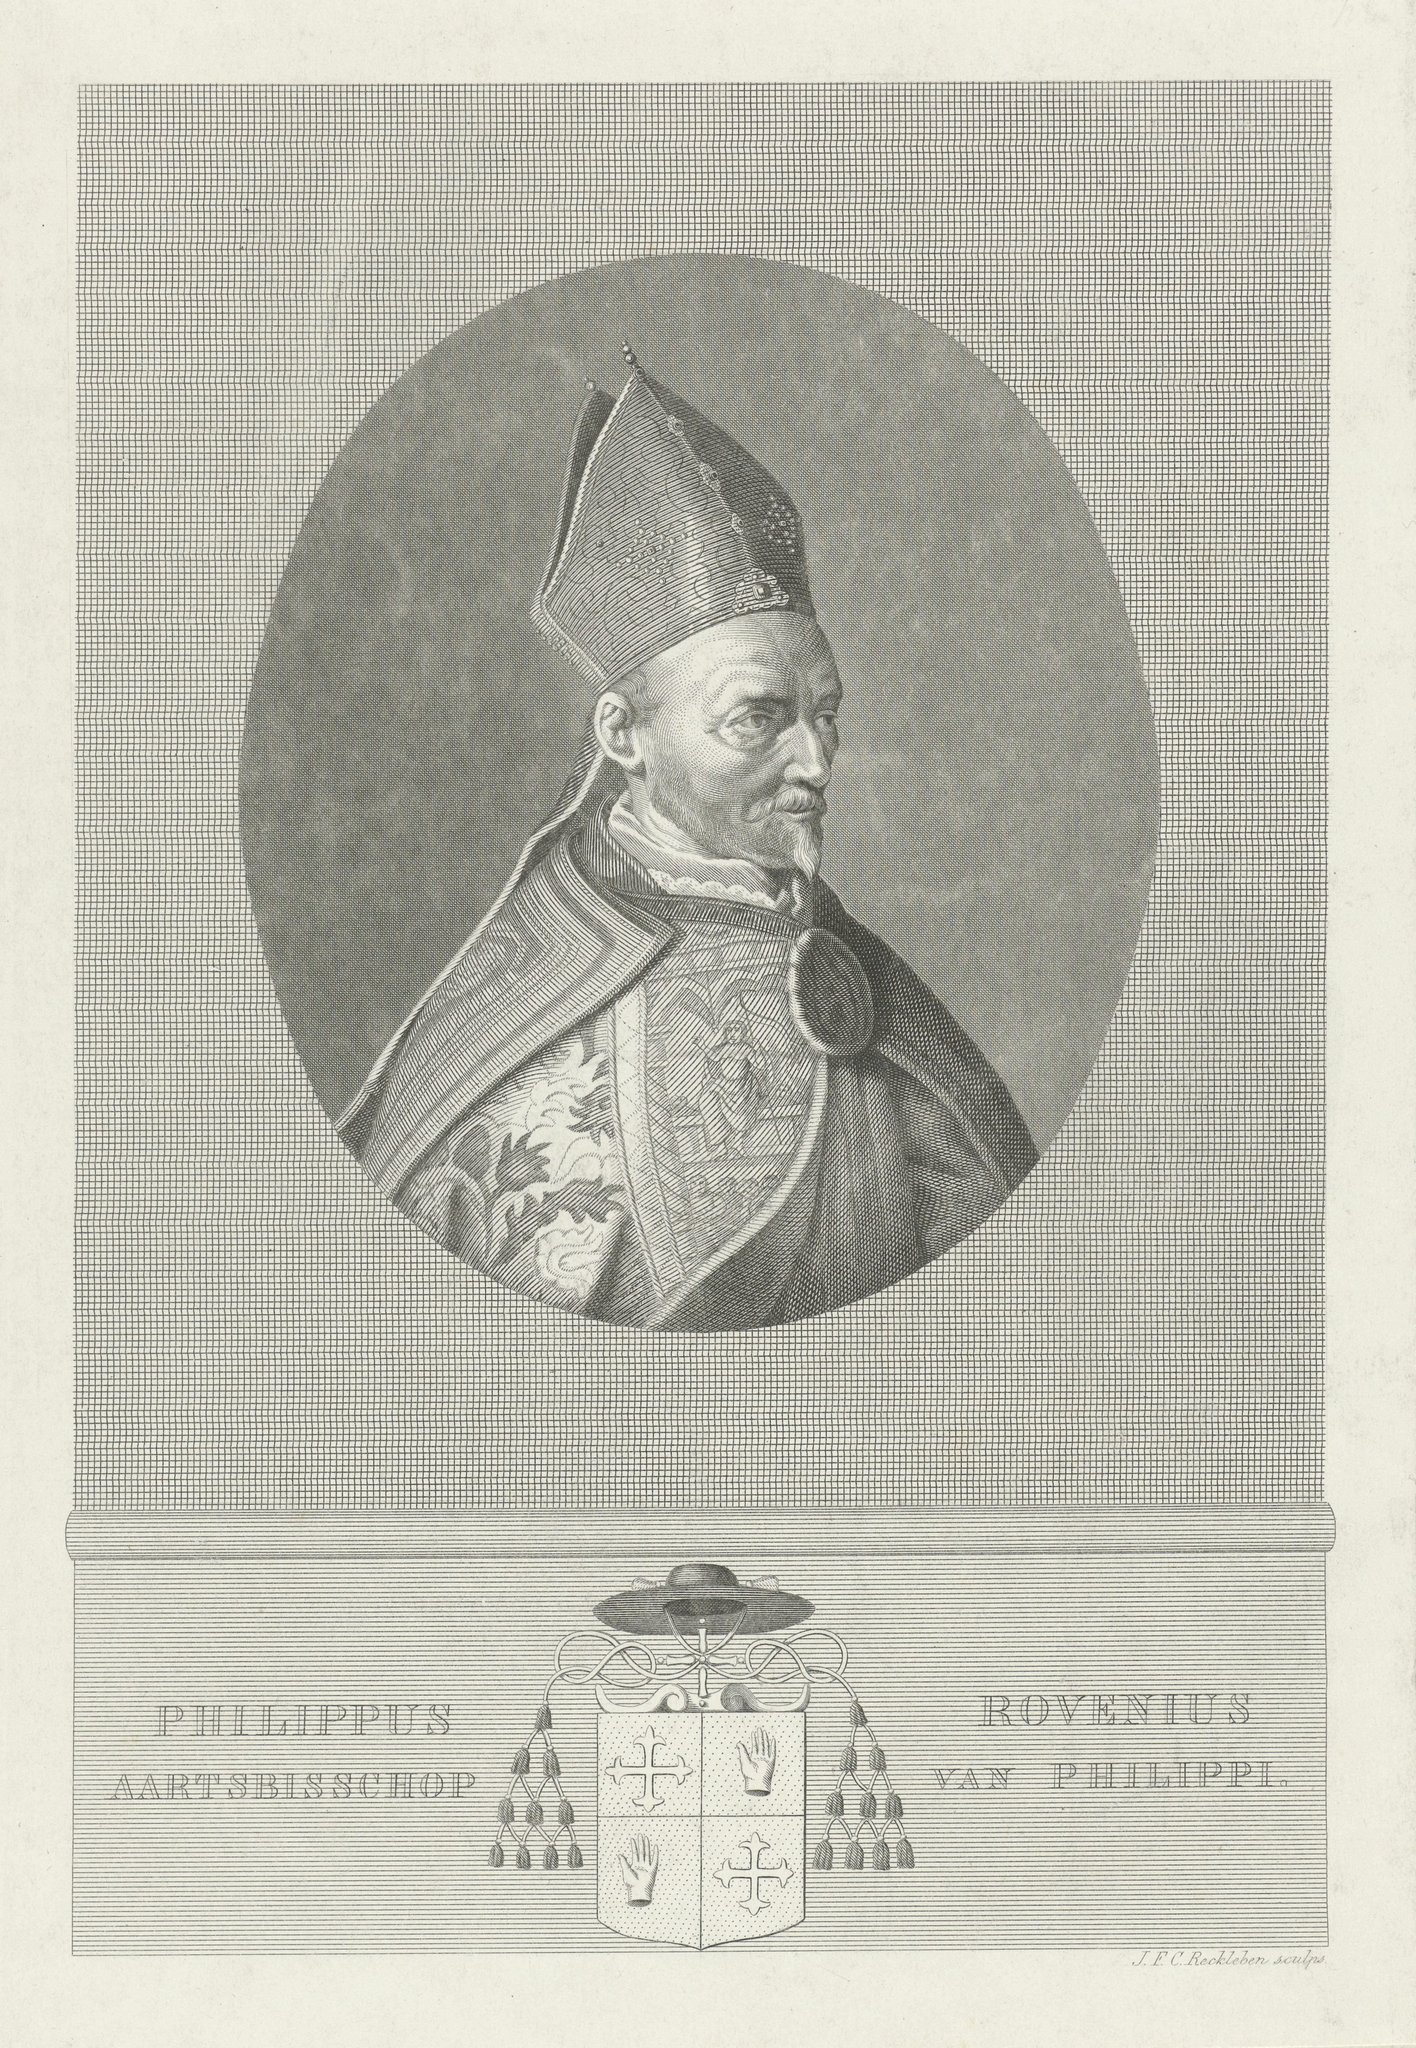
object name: book illustration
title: Portret van Filips van Rouveen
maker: jan frederik christiaan reckleben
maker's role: print maker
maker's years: 1819-1879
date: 1866-1868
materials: paper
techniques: engraving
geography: amsterdam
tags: clergyman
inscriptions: collector's mark: Lugt 2228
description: Illustratie in: Arend, Johannes Pieter. Algemeene geschiedenis des vaderlands van de vroegste tijden tot op heden. 5 delen, Amsterdam: Schleijer, J.F. 1840-1884, dl. 3.5, p. 319.